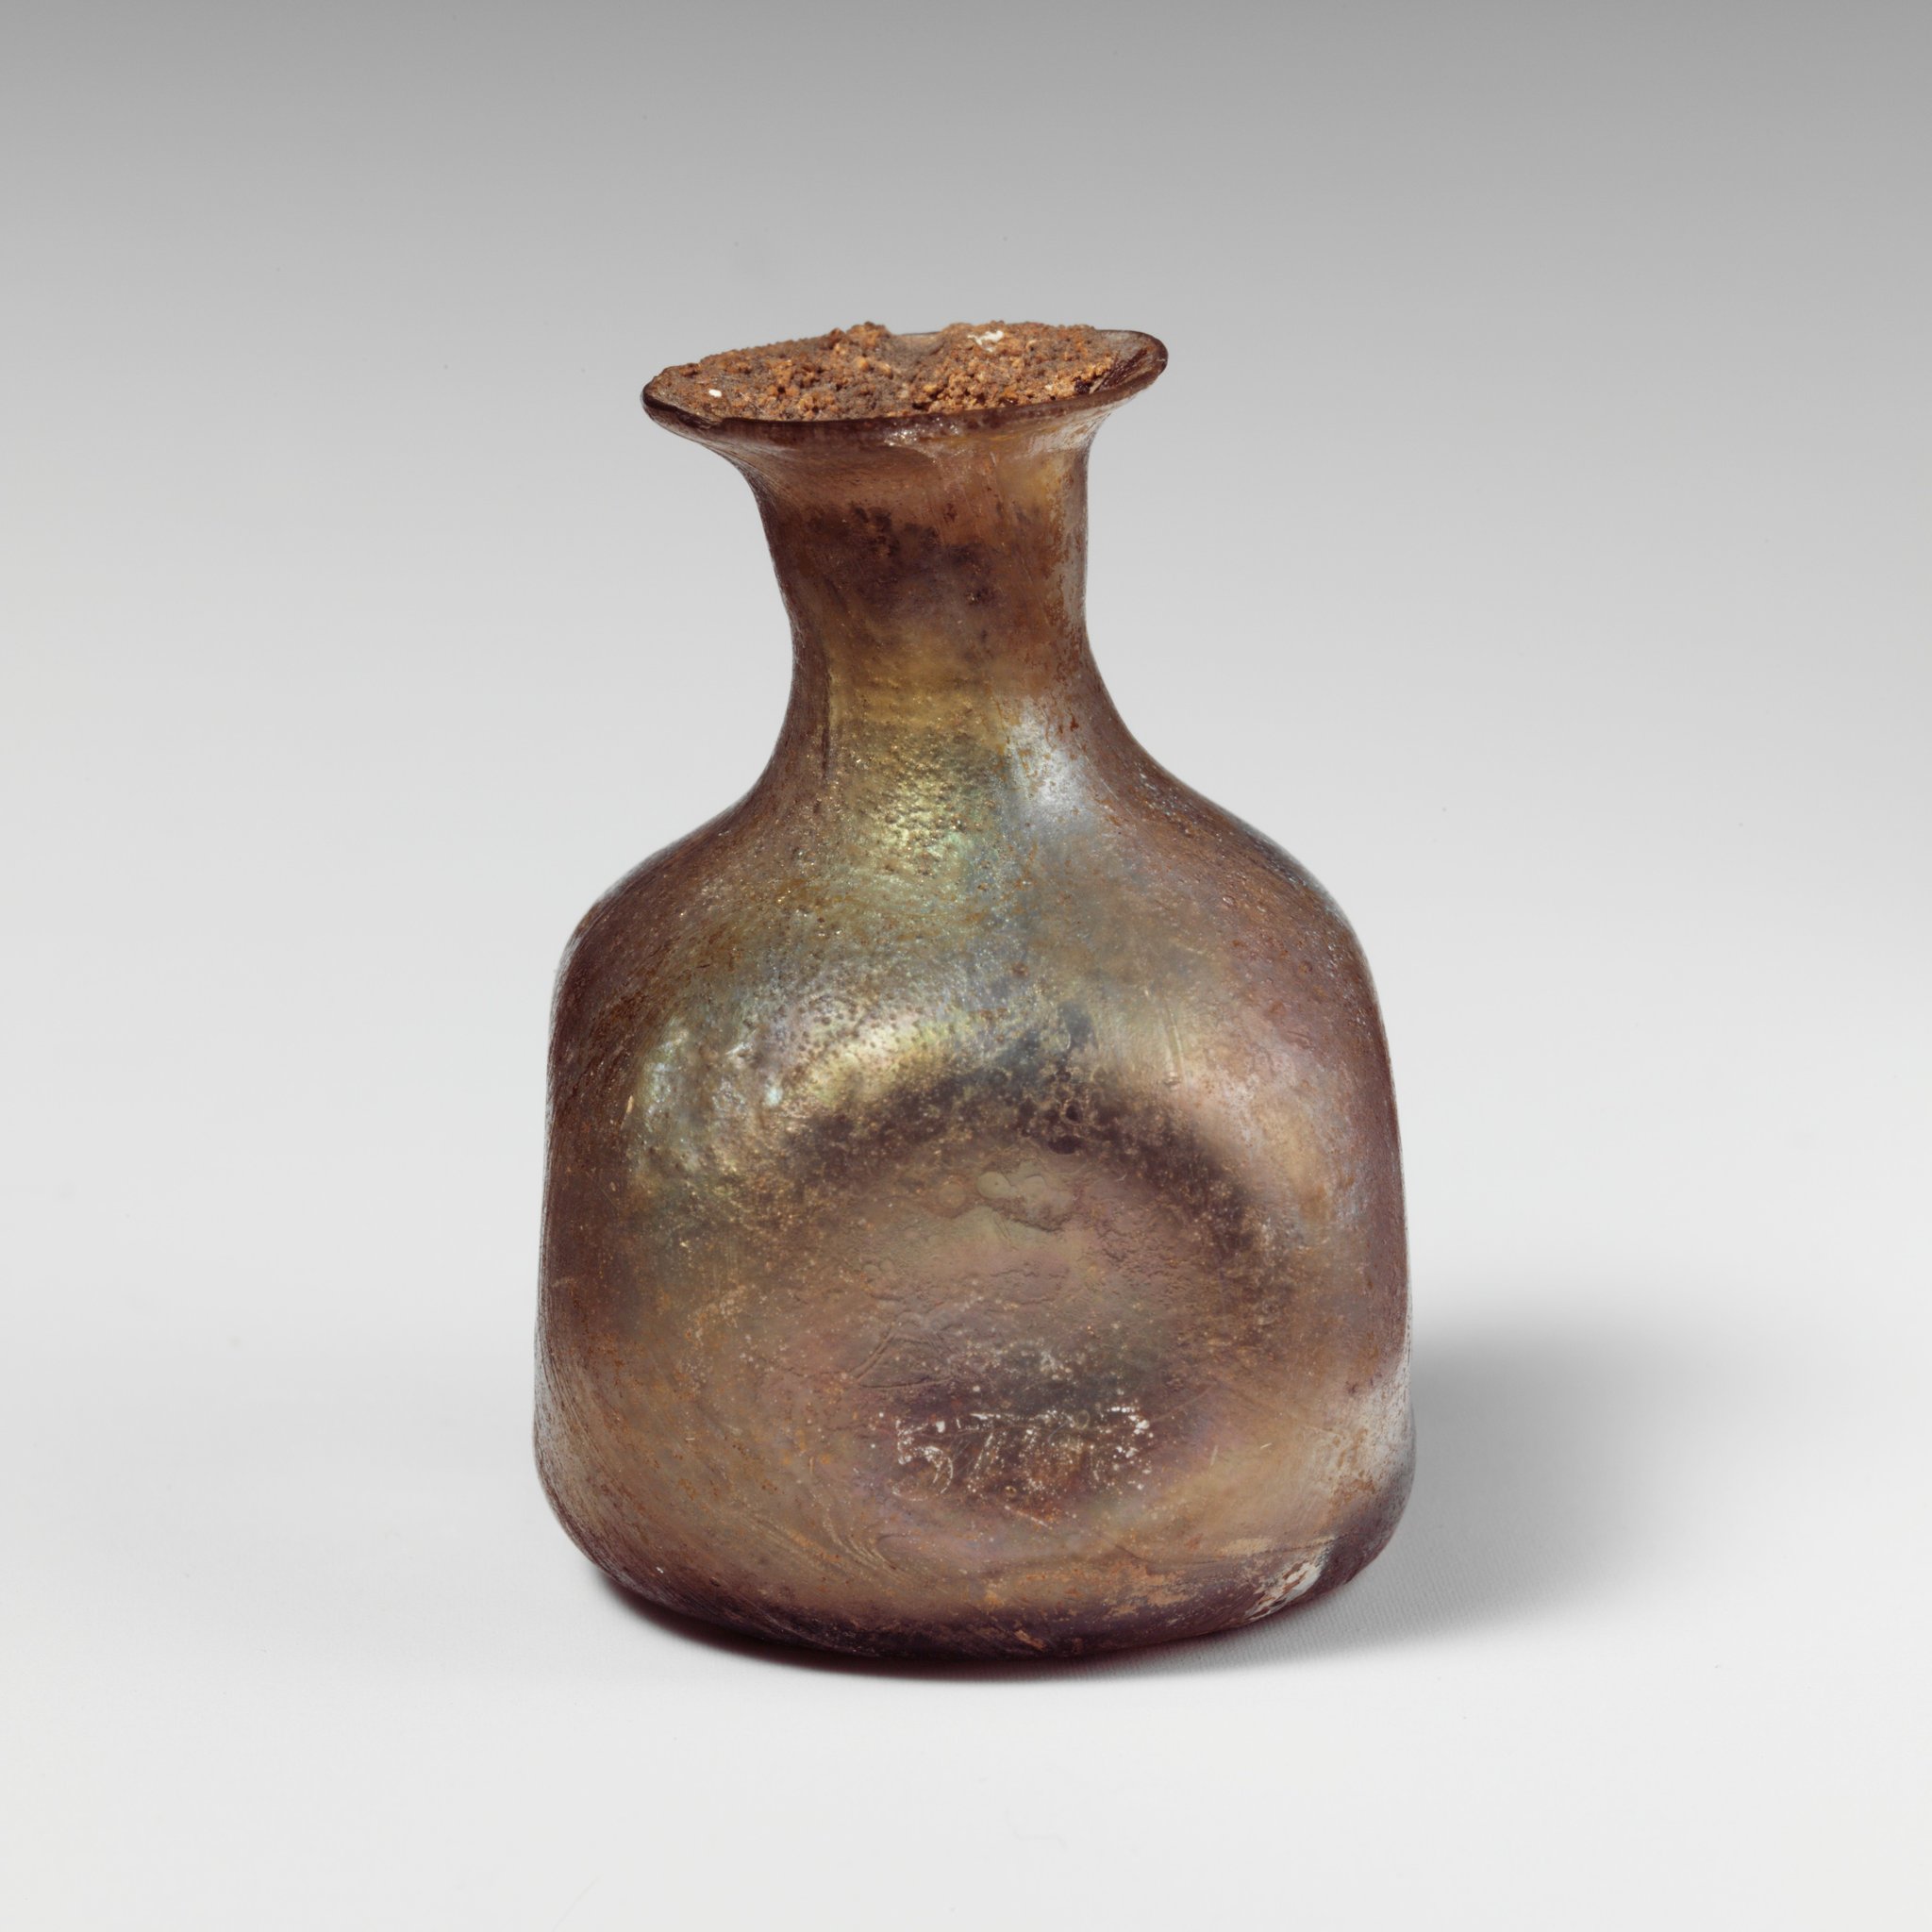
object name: bottle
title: Glass perfume bottle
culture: roman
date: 101-300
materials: glass